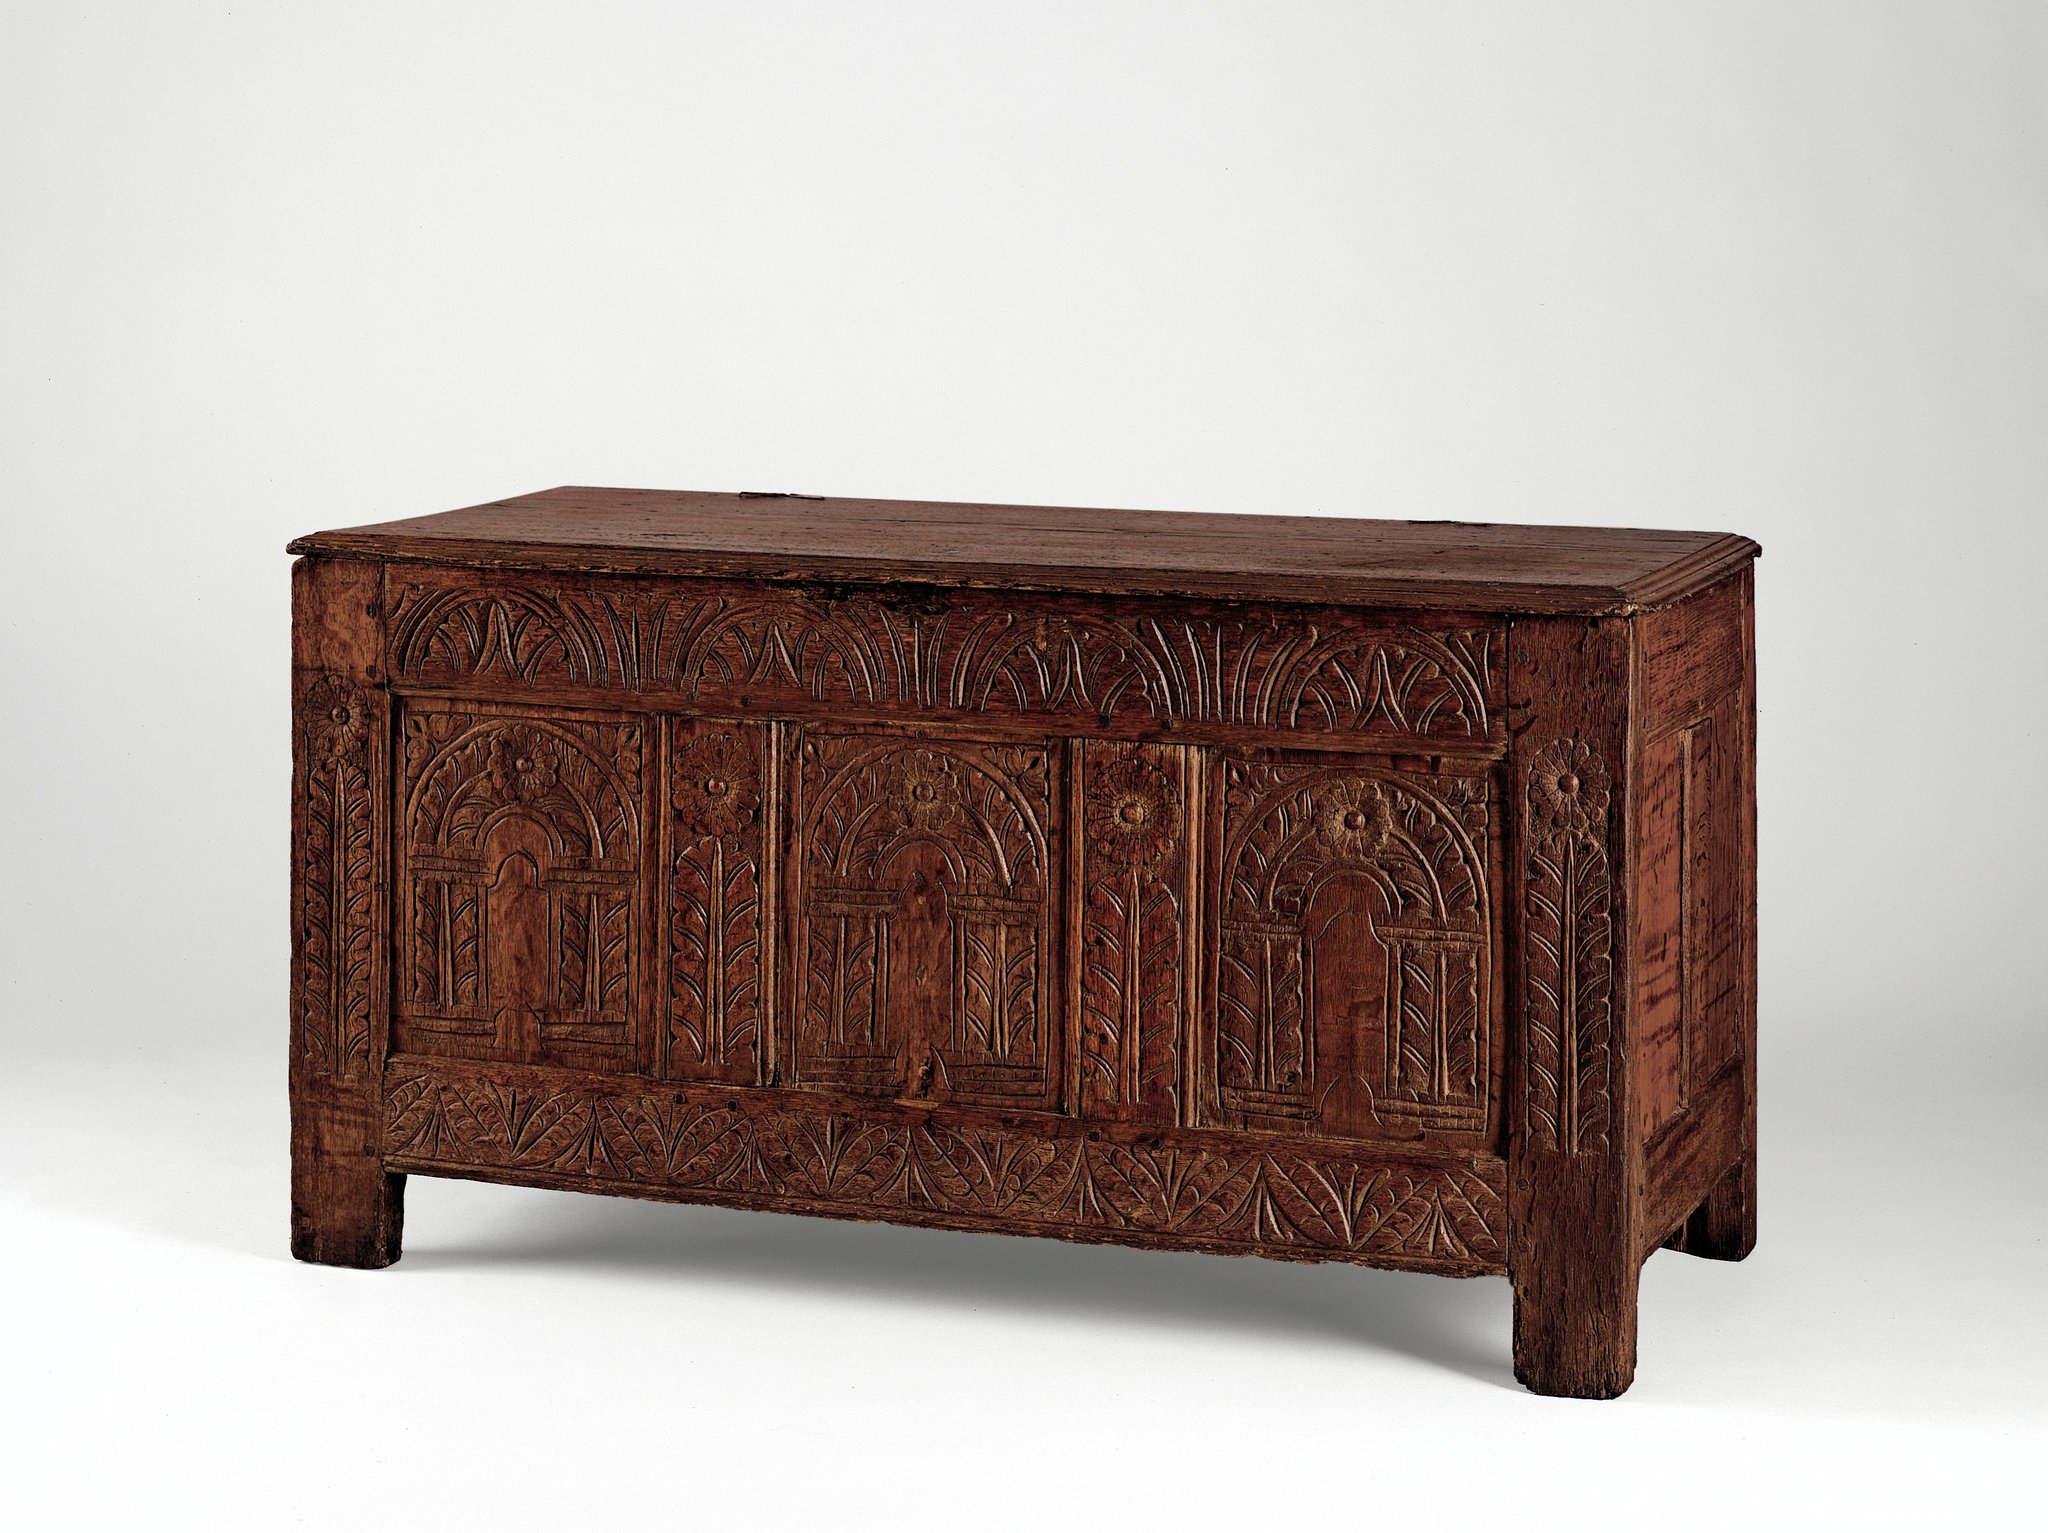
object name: chest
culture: american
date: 1640-1680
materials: wood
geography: united states